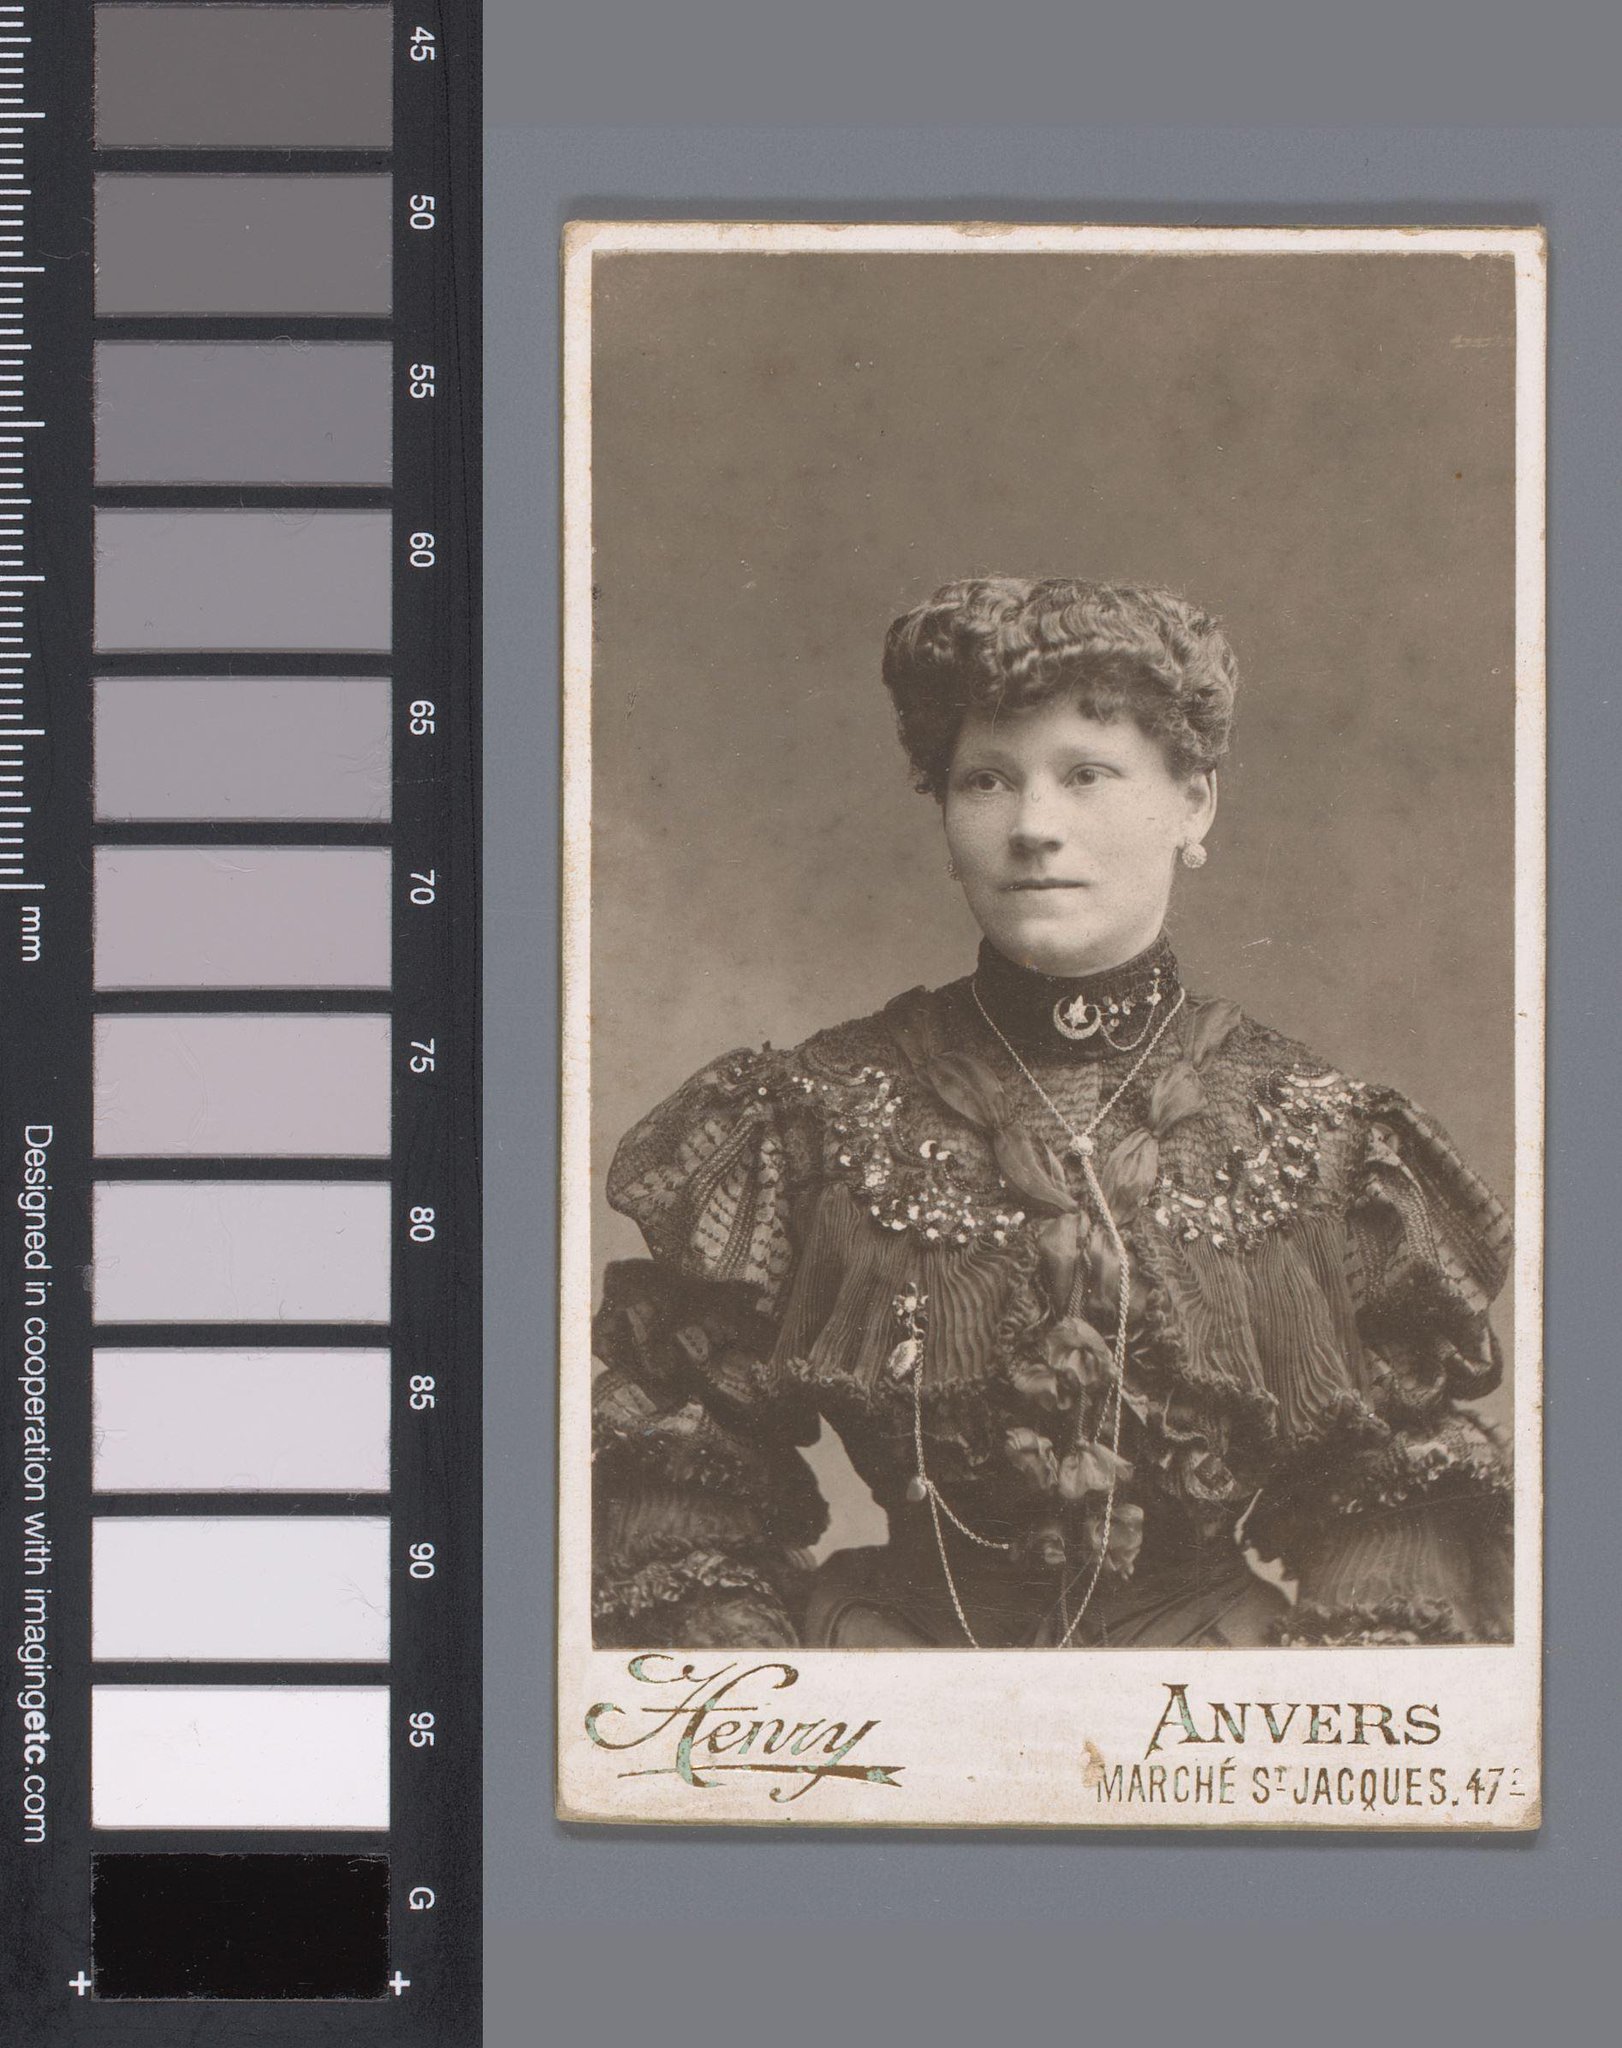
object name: carte de visite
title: Portret van een onbekende vrouw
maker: henri van boghout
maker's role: fotograaf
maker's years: 1861-1933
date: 1894-1900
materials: cardboard, photographic support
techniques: matte daylight collodion silver print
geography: antwerp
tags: historical persons - bb - woman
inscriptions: inscription: ‘Photographie/ Henry/ DIPLÔME A L'EXPOSITION/ UNIVERSELLE 1894/ ANVERS/ MARCHÉ ST. JACQUS 47 2/ ATELIER DE POSE AU JARDIN/ Les clichés sont conservés * De platen worden bewaard.’